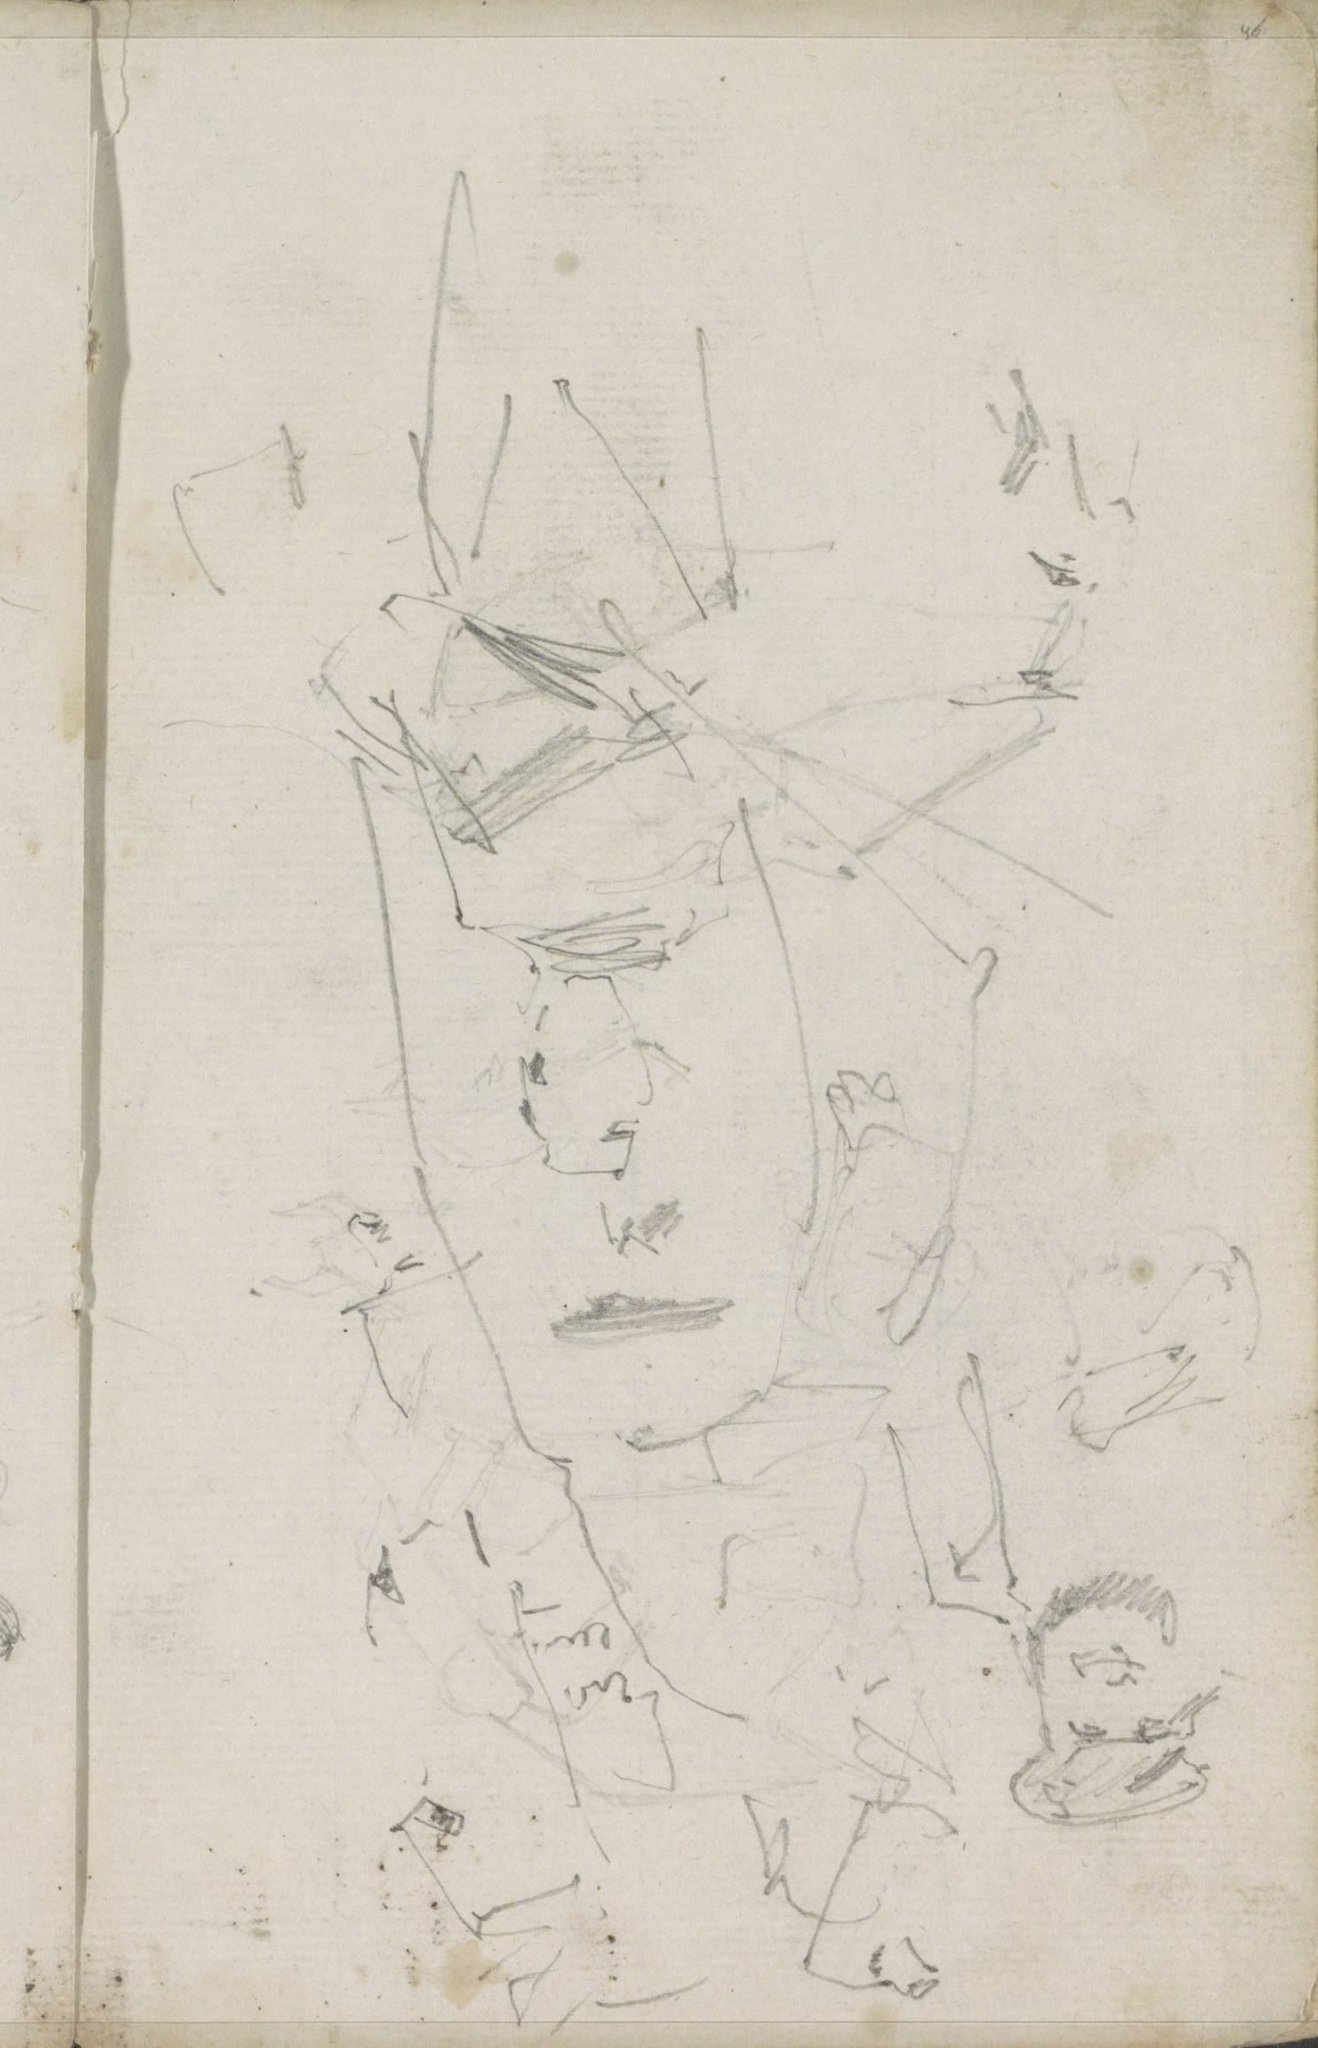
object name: sketchbook leaf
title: Figuurstudies en een paardenhoofd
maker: george hendrik breitner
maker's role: draughtsman, painter, print maker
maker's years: 1857-1923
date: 1880-1882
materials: paper, pencil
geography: the hague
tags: head (human), adult woman, horse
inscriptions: annotation: ‘[...]’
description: Pagina 46 uit een schetsboek met 29 bladen.